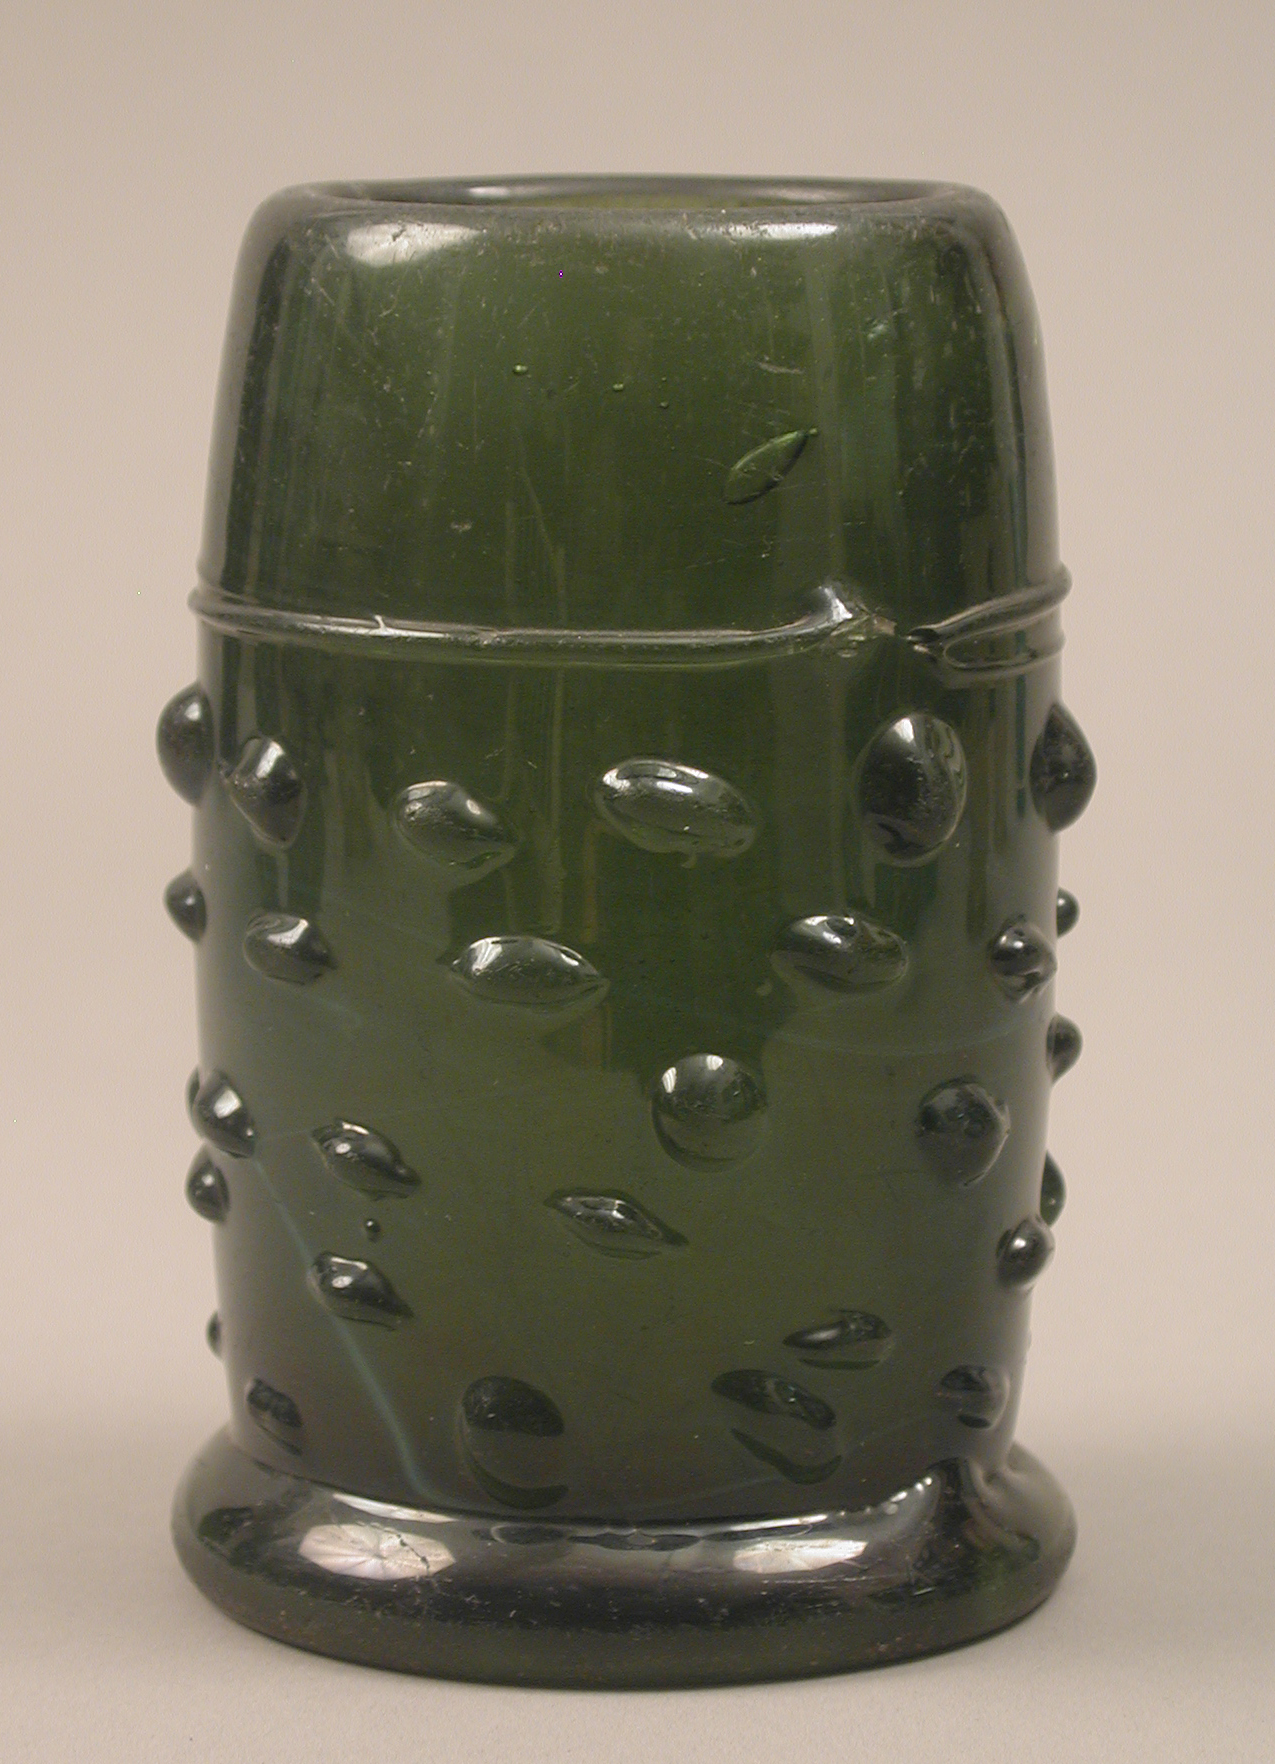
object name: mortar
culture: german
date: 1401-1600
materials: glass